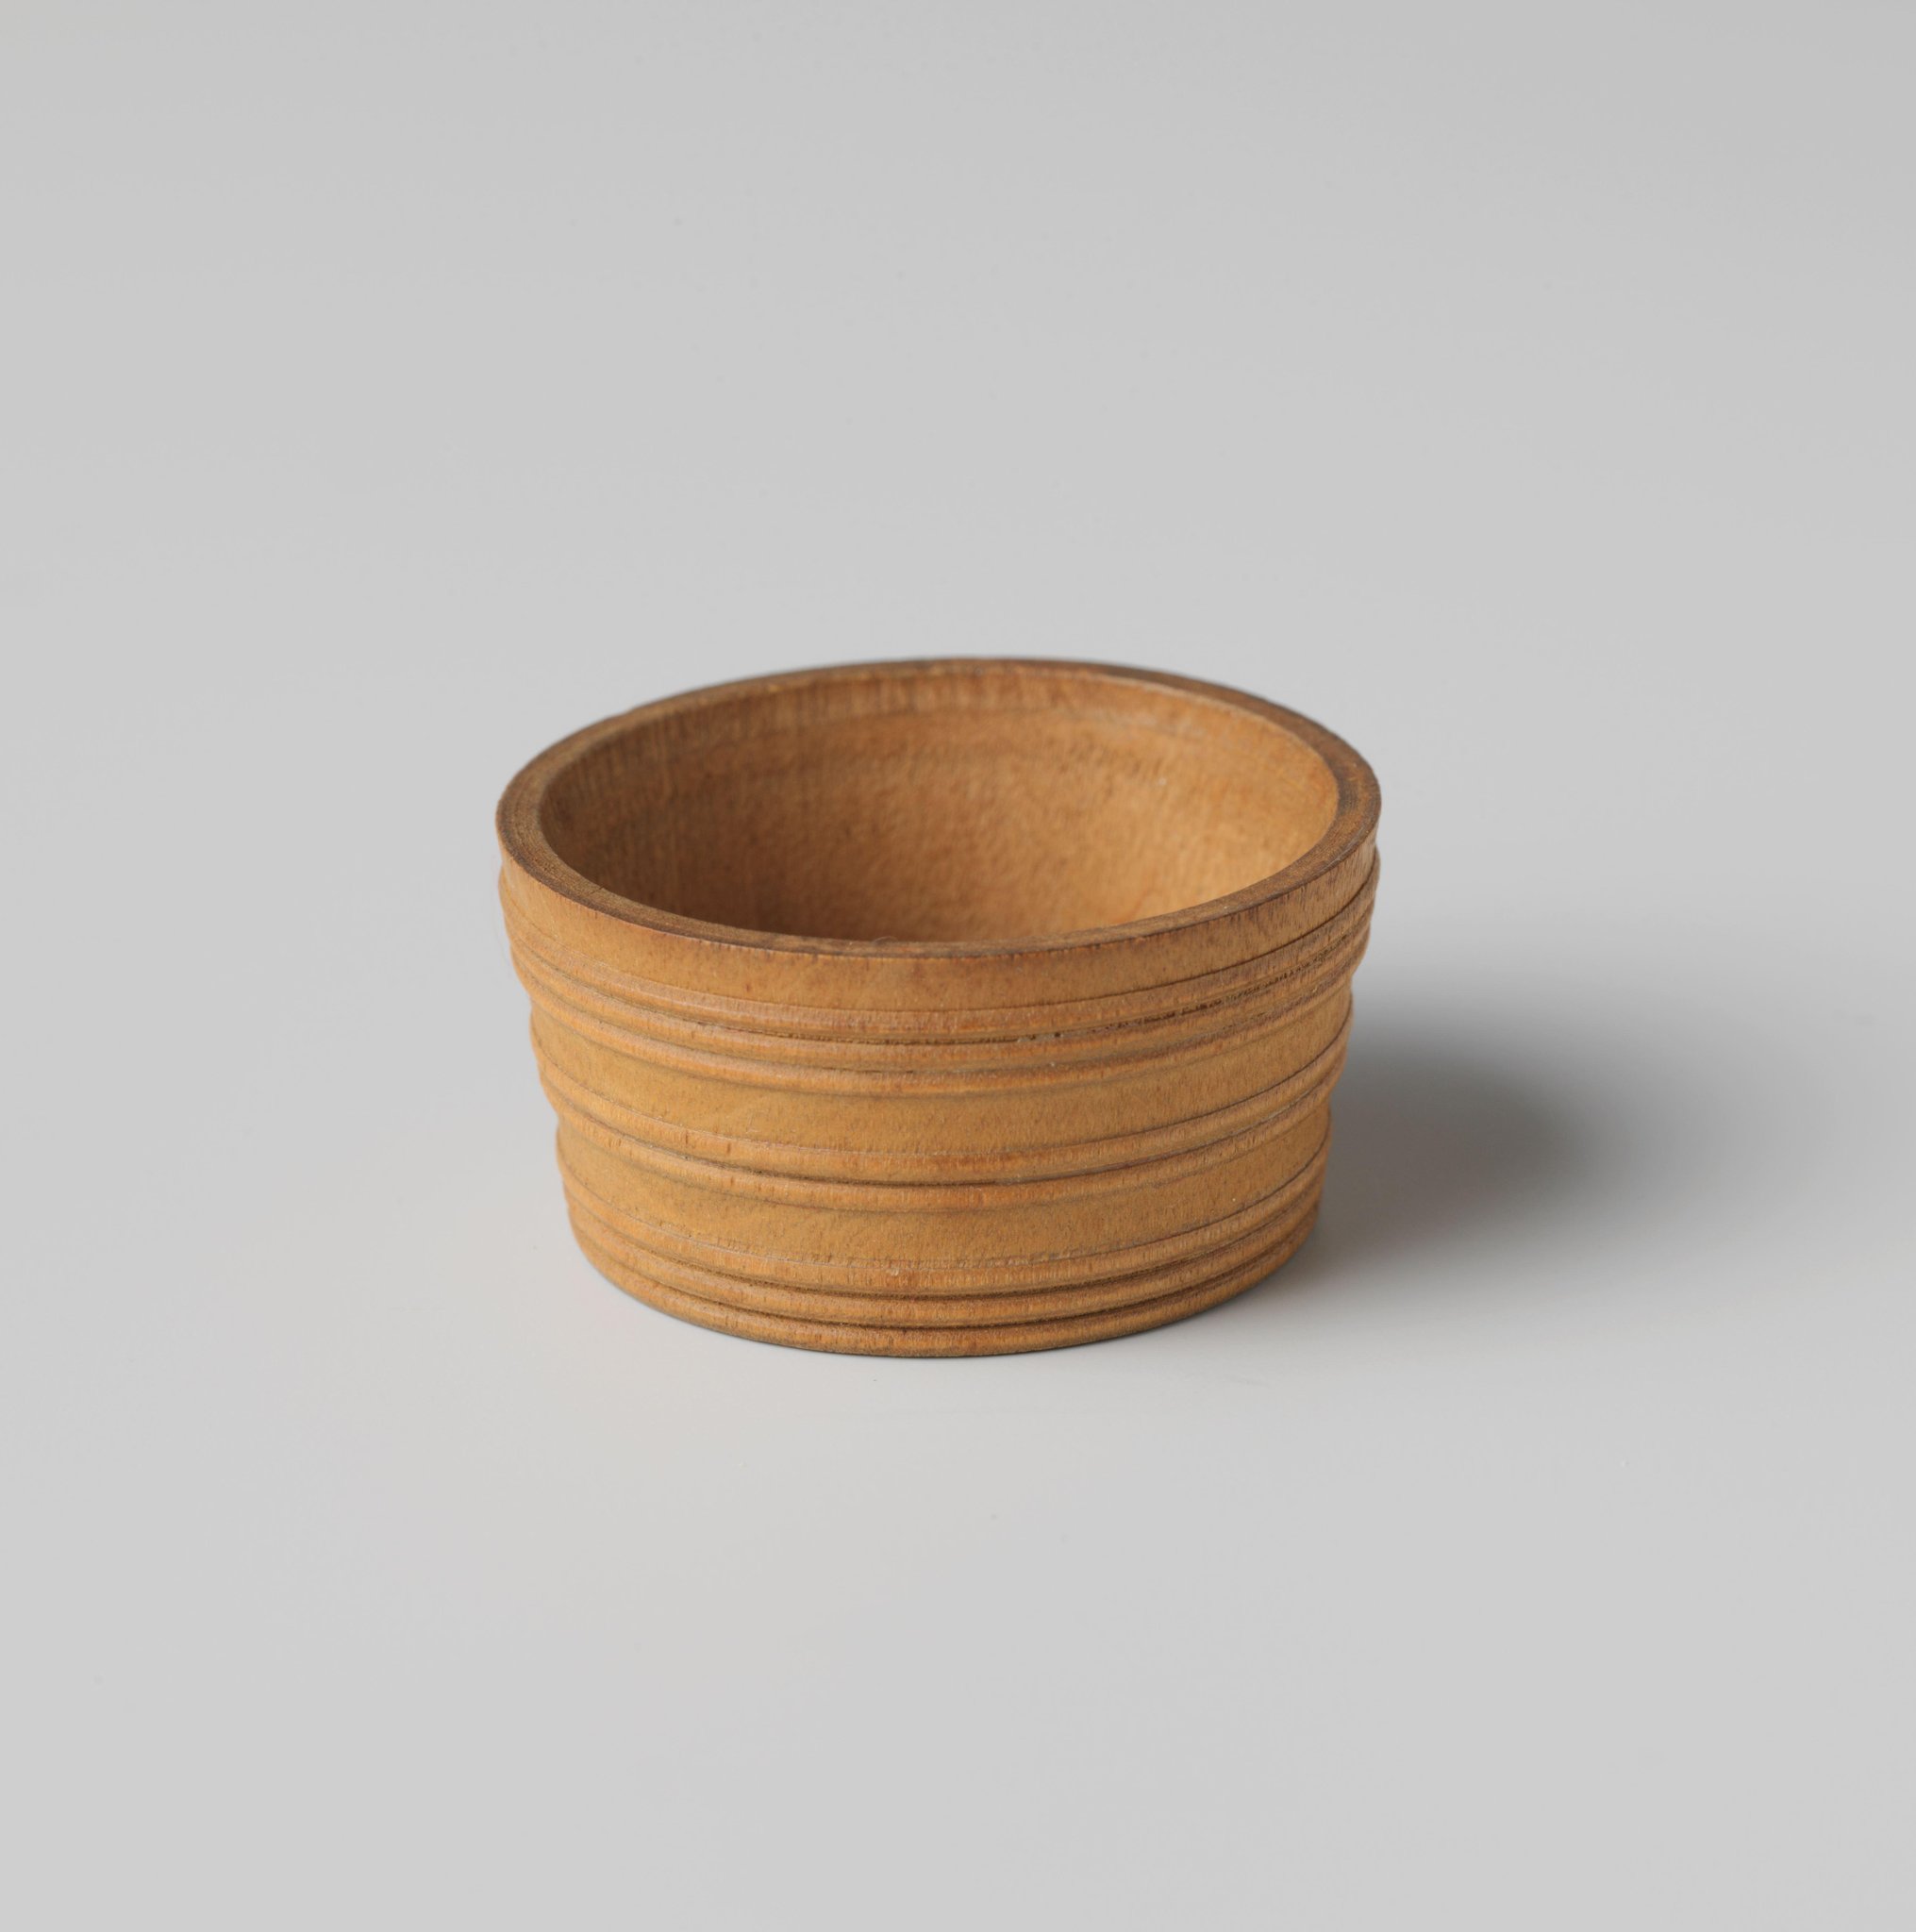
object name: tub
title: Tobbe met profielrand, gedraaid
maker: Anonymous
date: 1675-1700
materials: wood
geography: amsterdam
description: Een tobbe gedraaid van esdoornhout met profielrand.